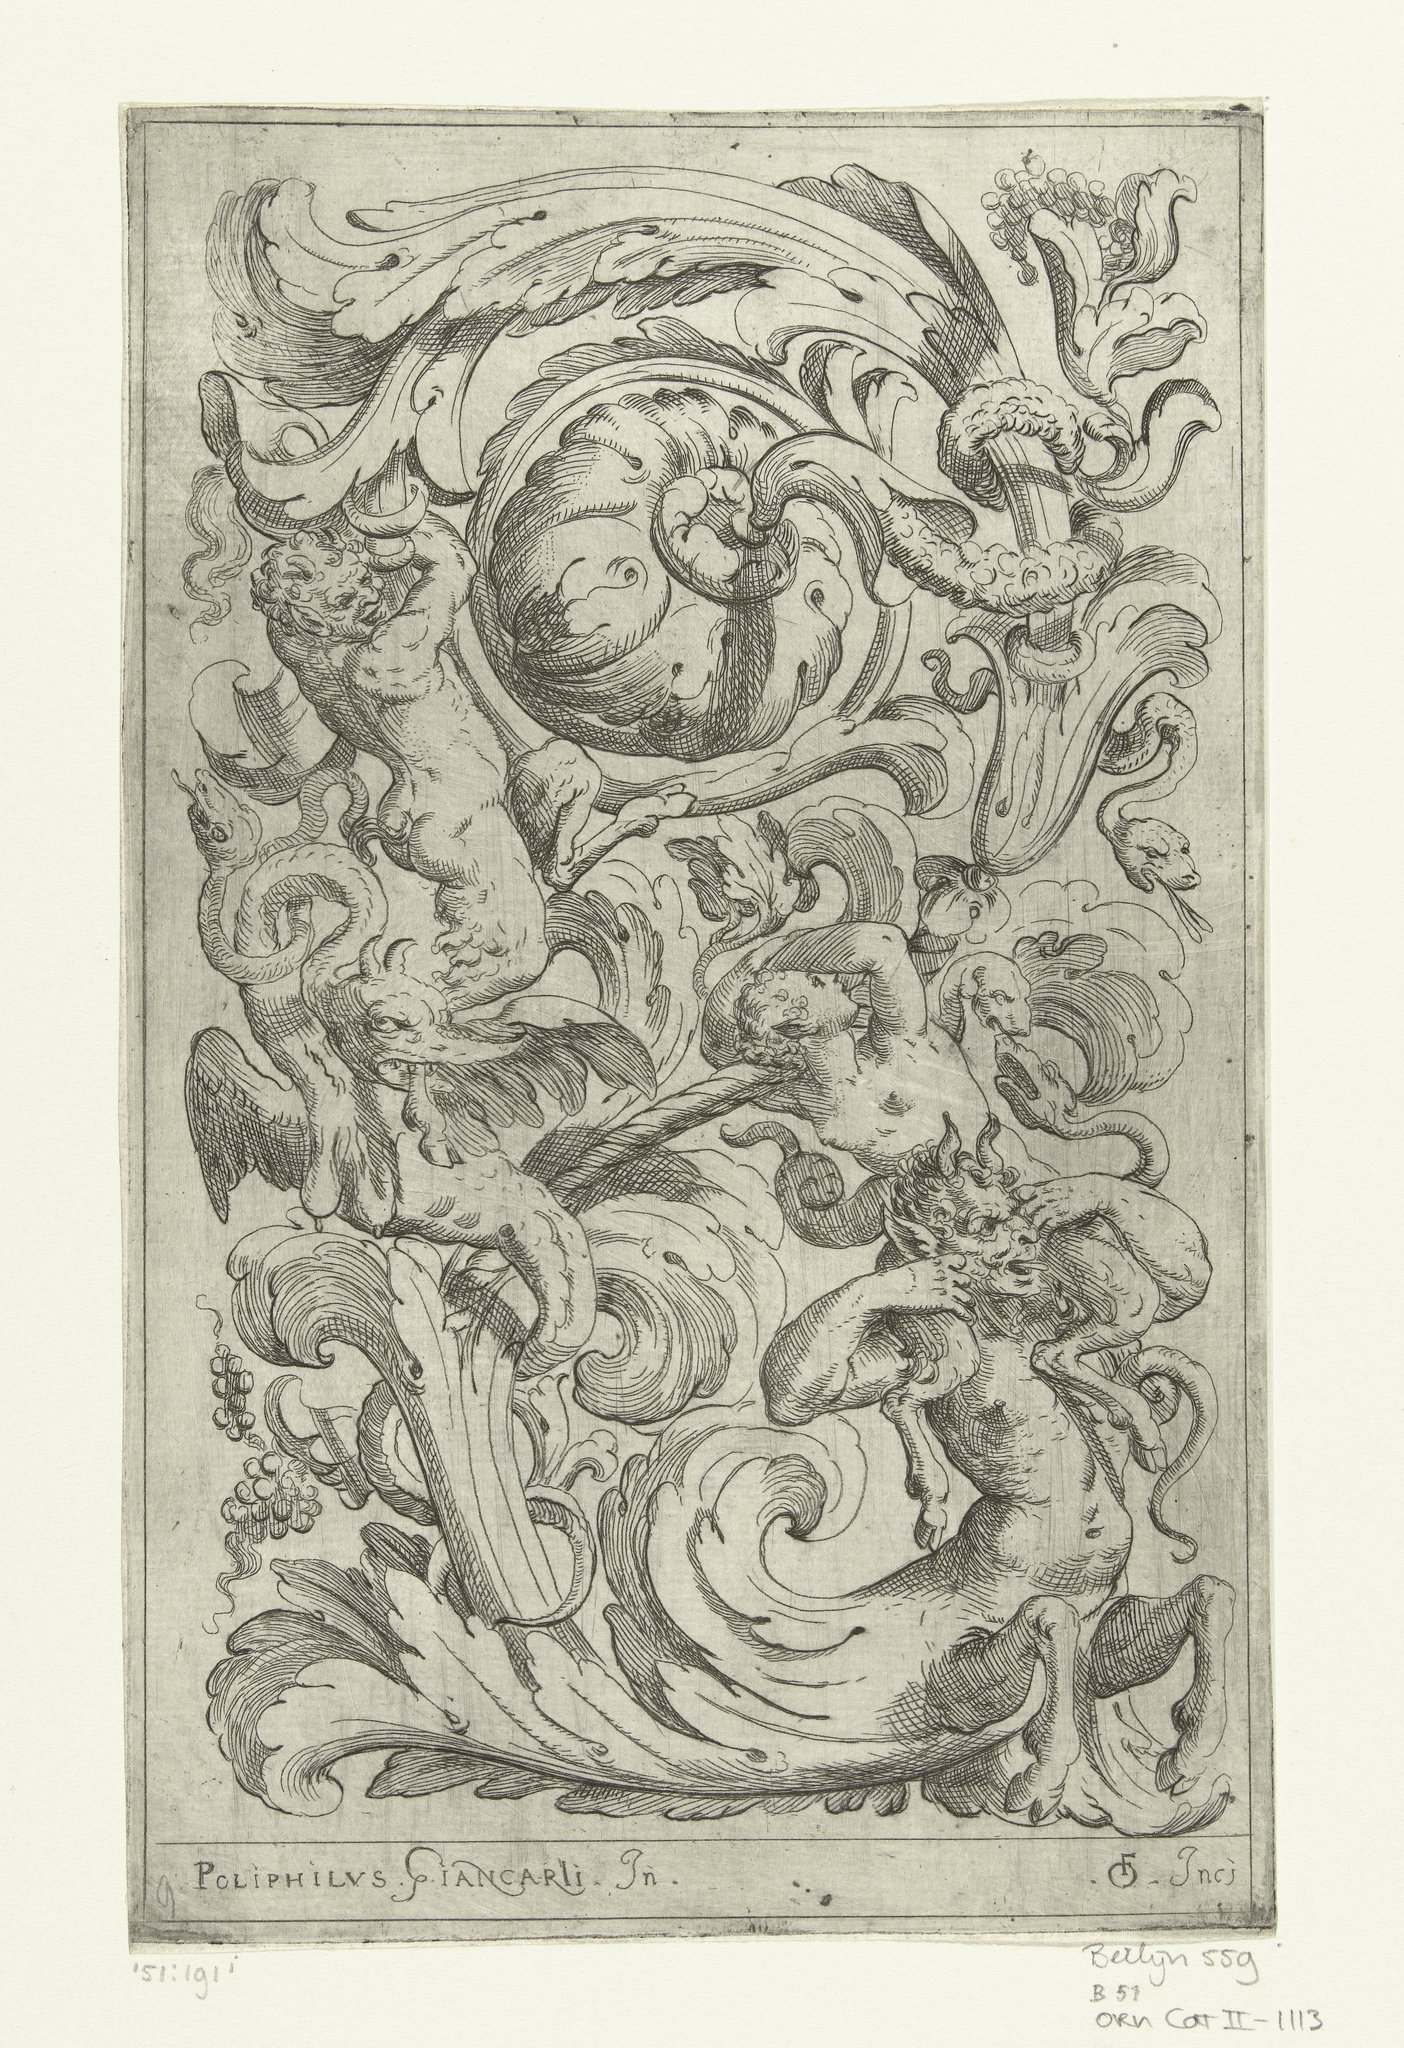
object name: print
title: Disegni varii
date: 1625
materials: paper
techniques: etching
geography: venice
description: De sater rechtsonder draagt een vrouwelijke sater op zijn schouders, linksboven hangt een sater aan een bladrank. Blad uit serie van 10 bladen met verticale panelen vol bladranken, figuren en dieren.